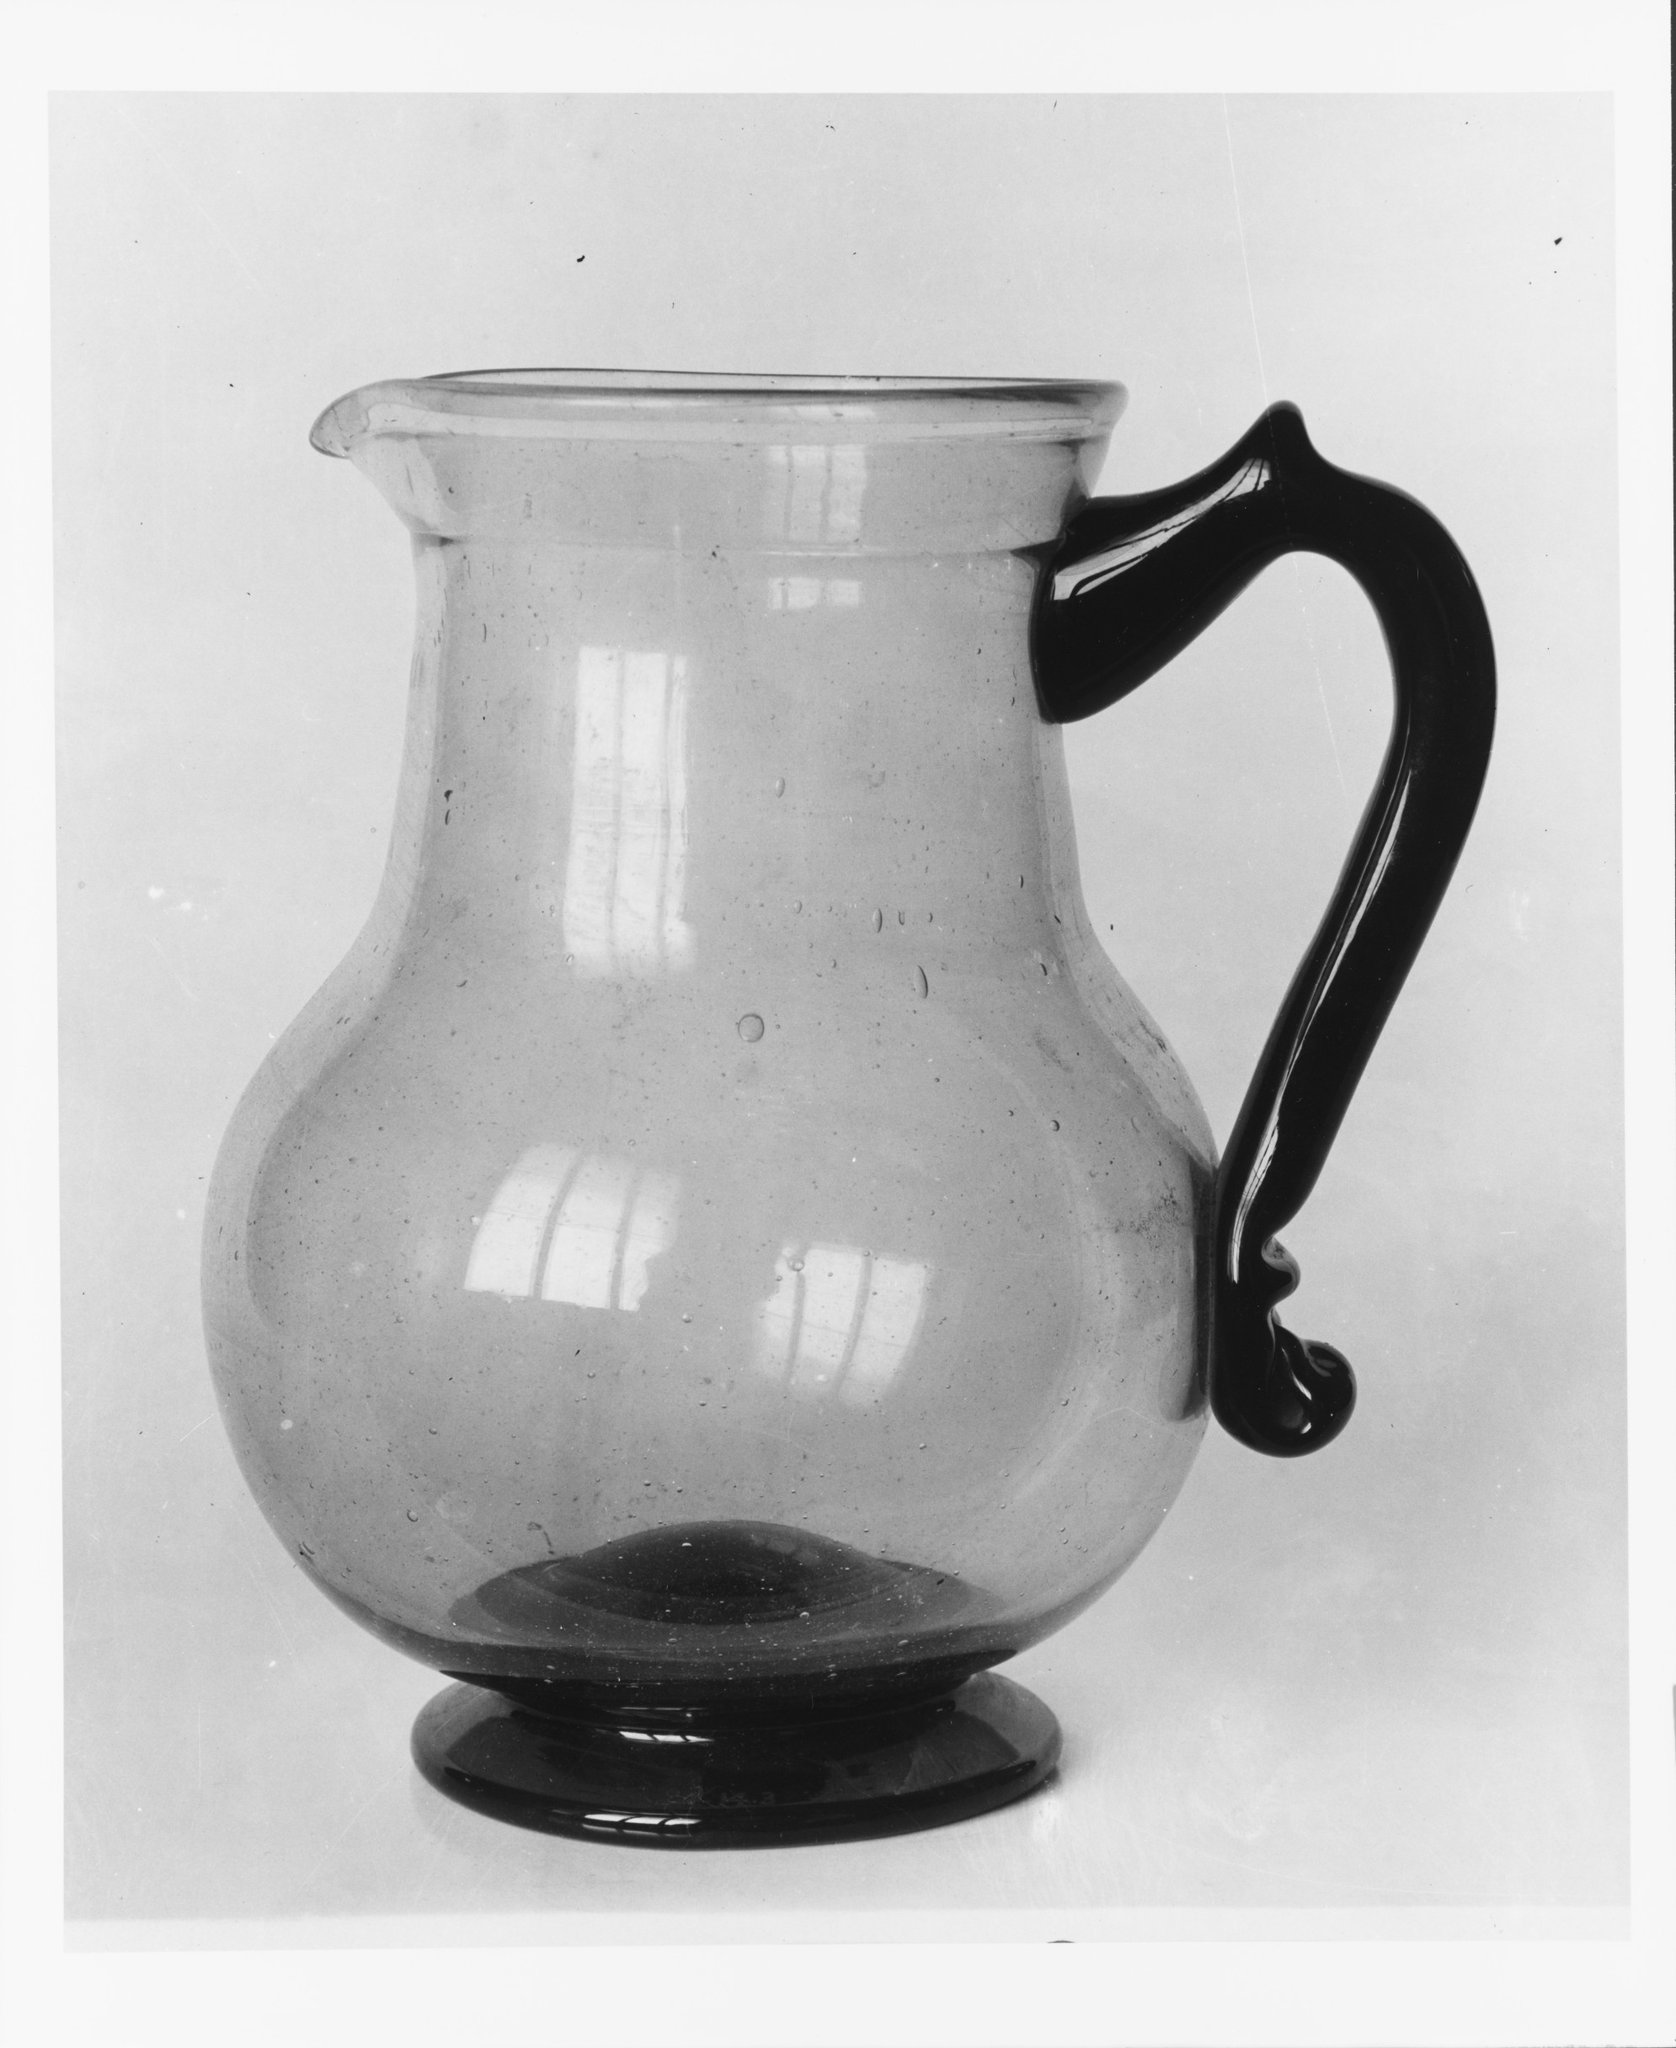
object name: pitcher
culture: american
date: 1700-1800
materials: amber, glass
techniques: glassblowing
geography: united states